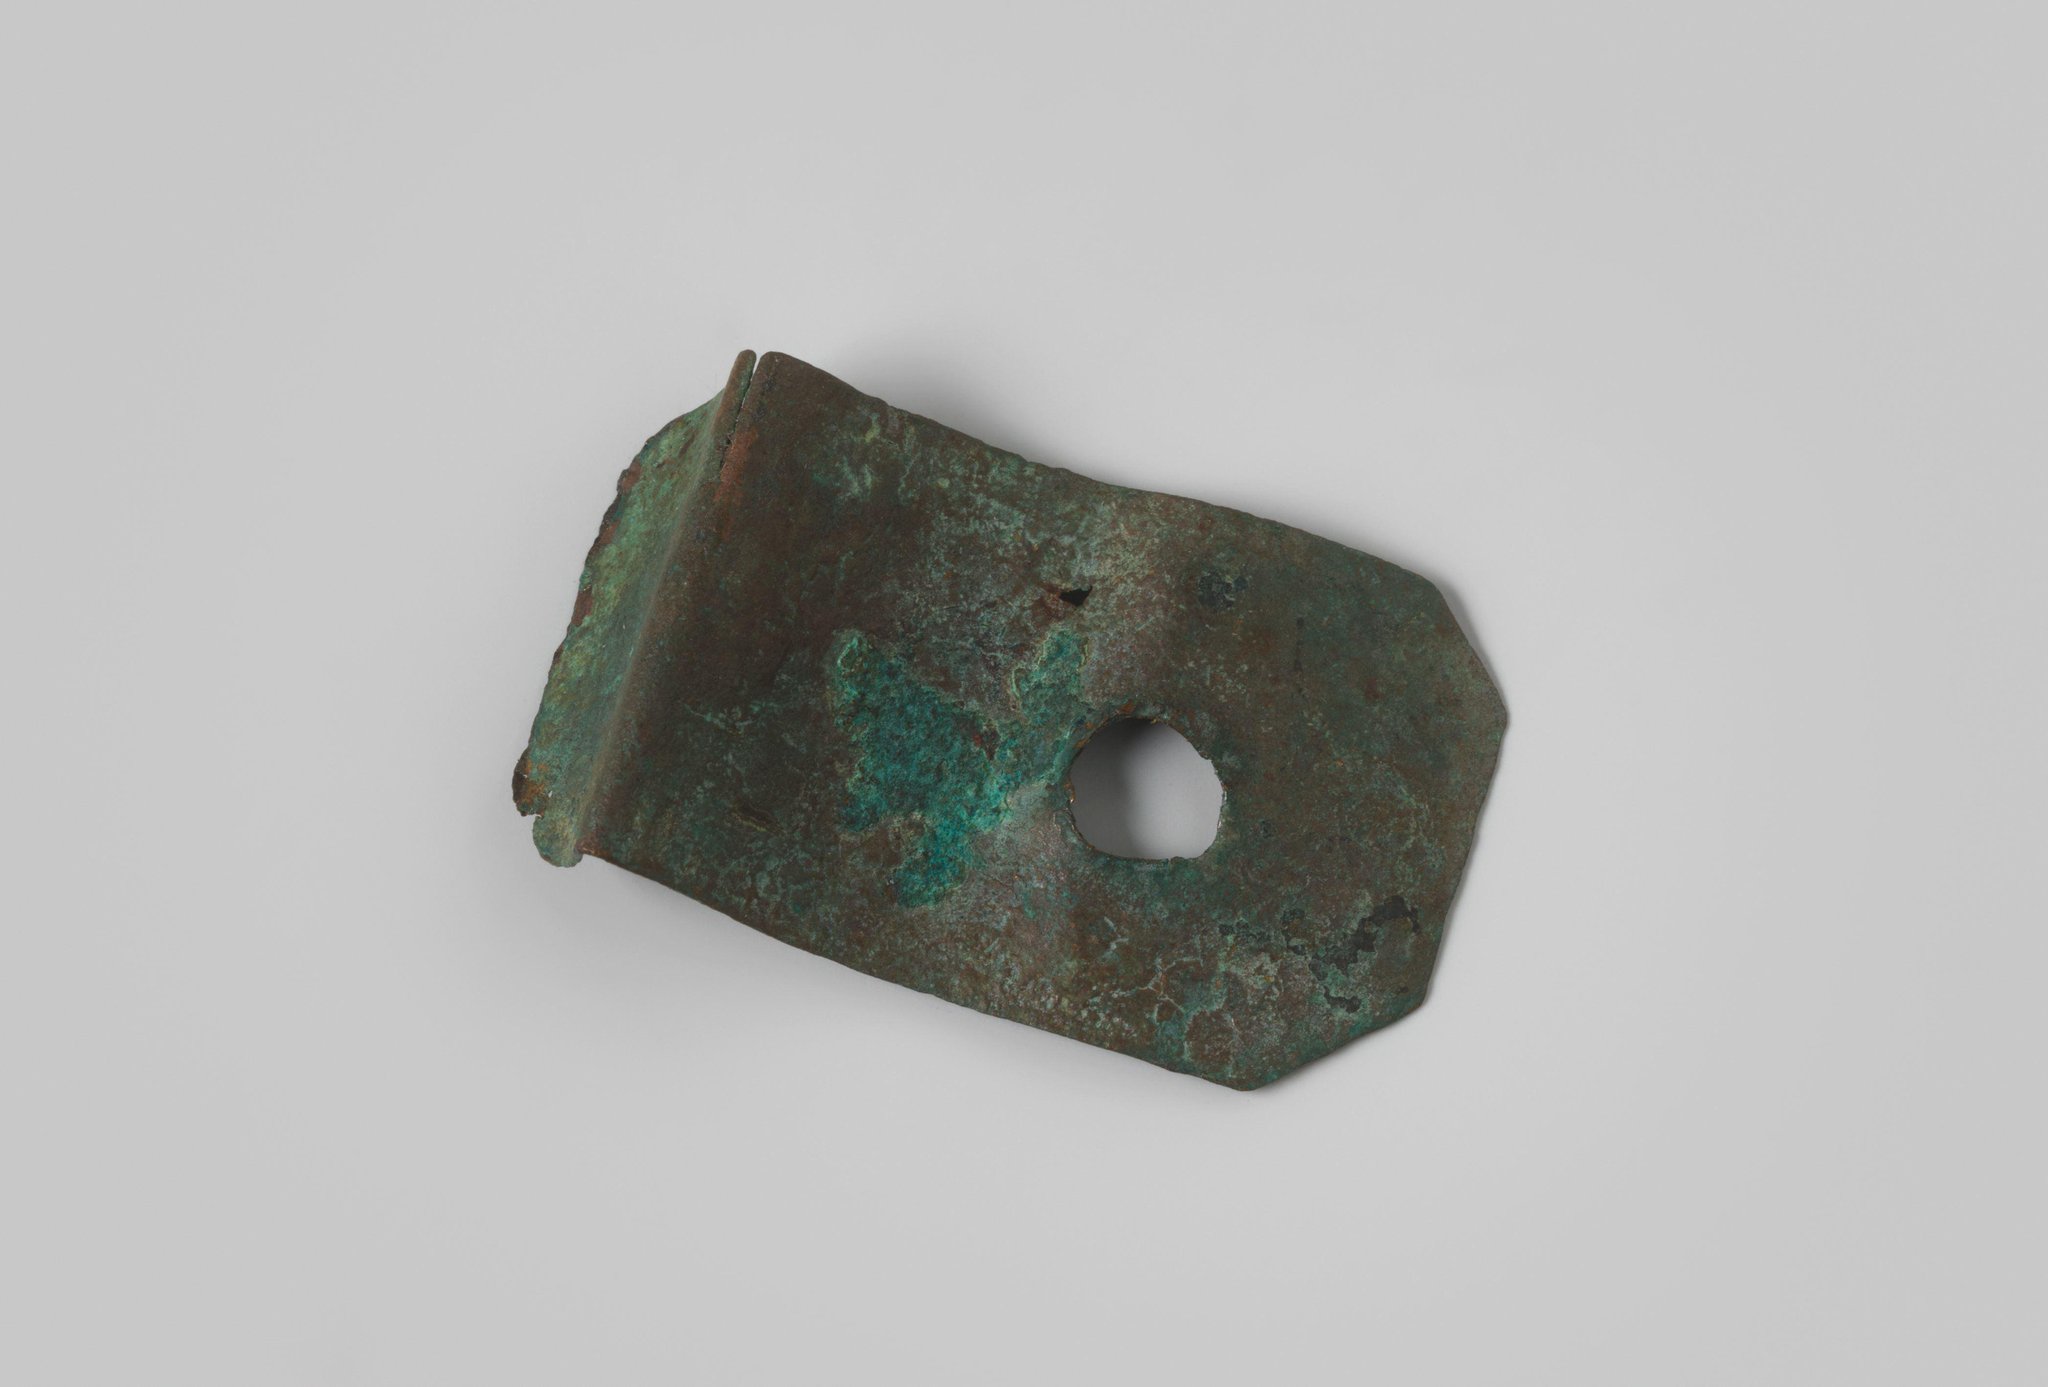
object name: lug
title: Oor van een kardoeskoker uit het wrak van de Oost-Indiëvaarder Hollandia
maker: Anonymous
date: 1700-1743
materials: copper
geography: netherlands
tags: verenigde oostindische compagnie, hollandia (schip), annet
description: Cartridge canister, lug; fragm of strip, cut-corner end with rivet-hole, sim. NG 1980-27H2394.